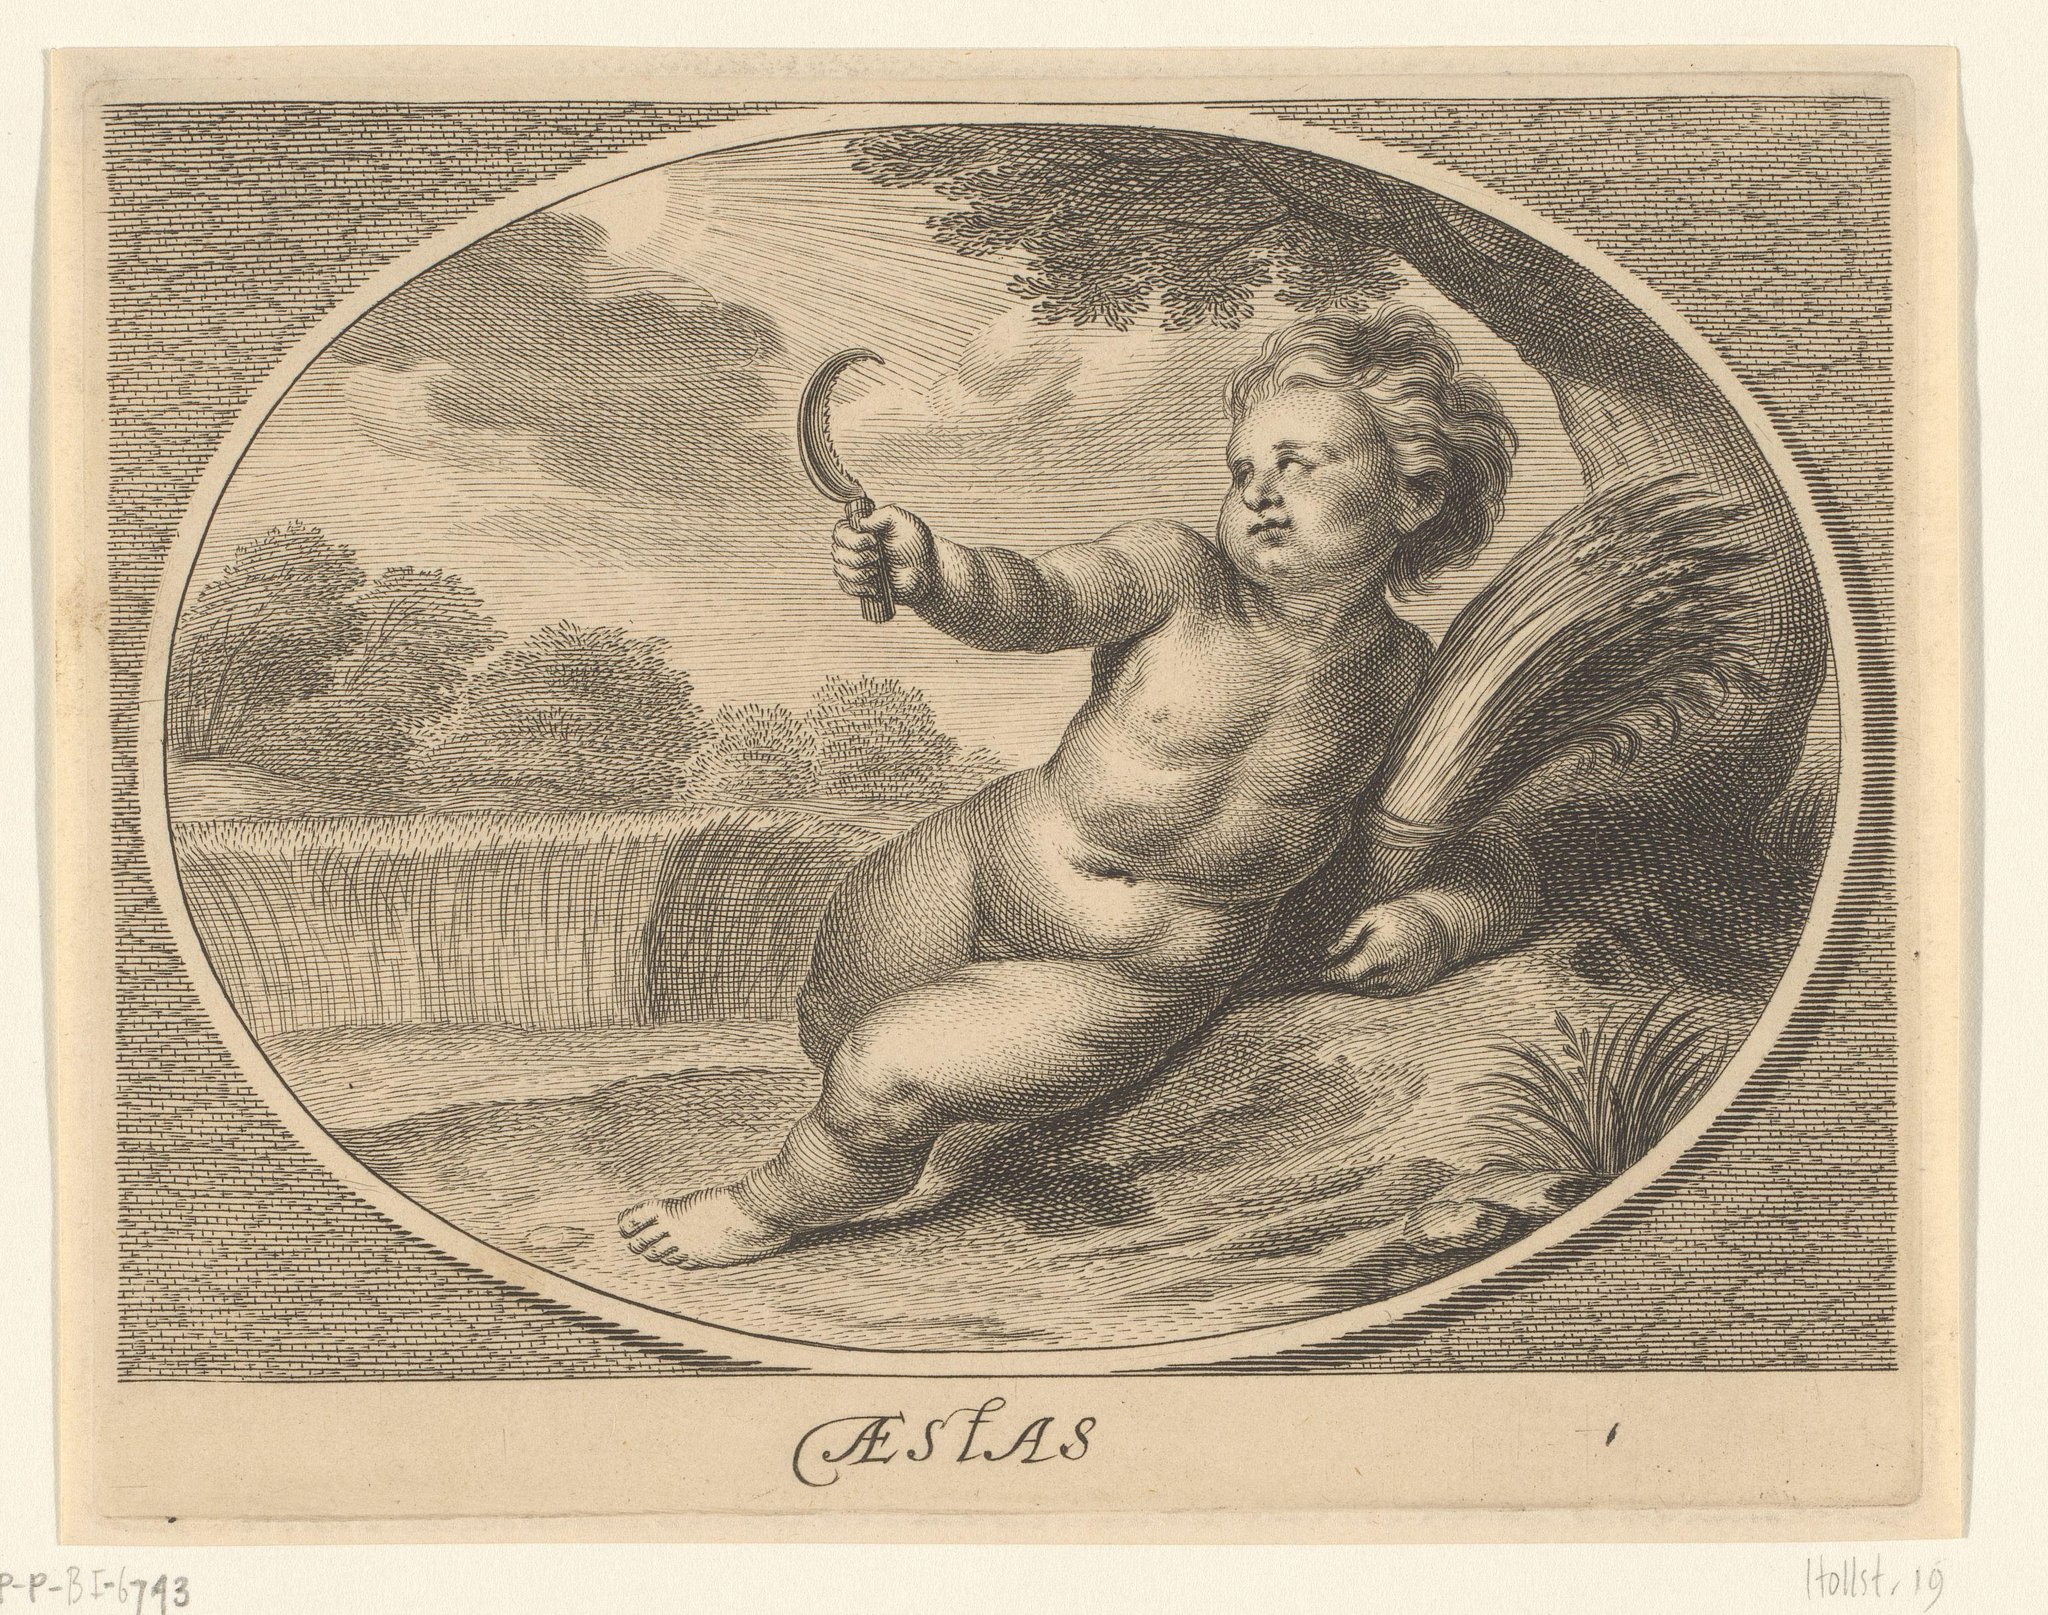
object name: print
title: Zomer in gedaante van kind met zeis en korenschoof bij korenveld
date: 1648-1664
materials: paper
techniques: engraving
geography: amsterdam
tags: summer, 'aestas'; 'estate' (ripa)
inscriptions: collector's mark: Lugt 240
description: Prent uit serie van vier prenten met de vier jaargetijden.